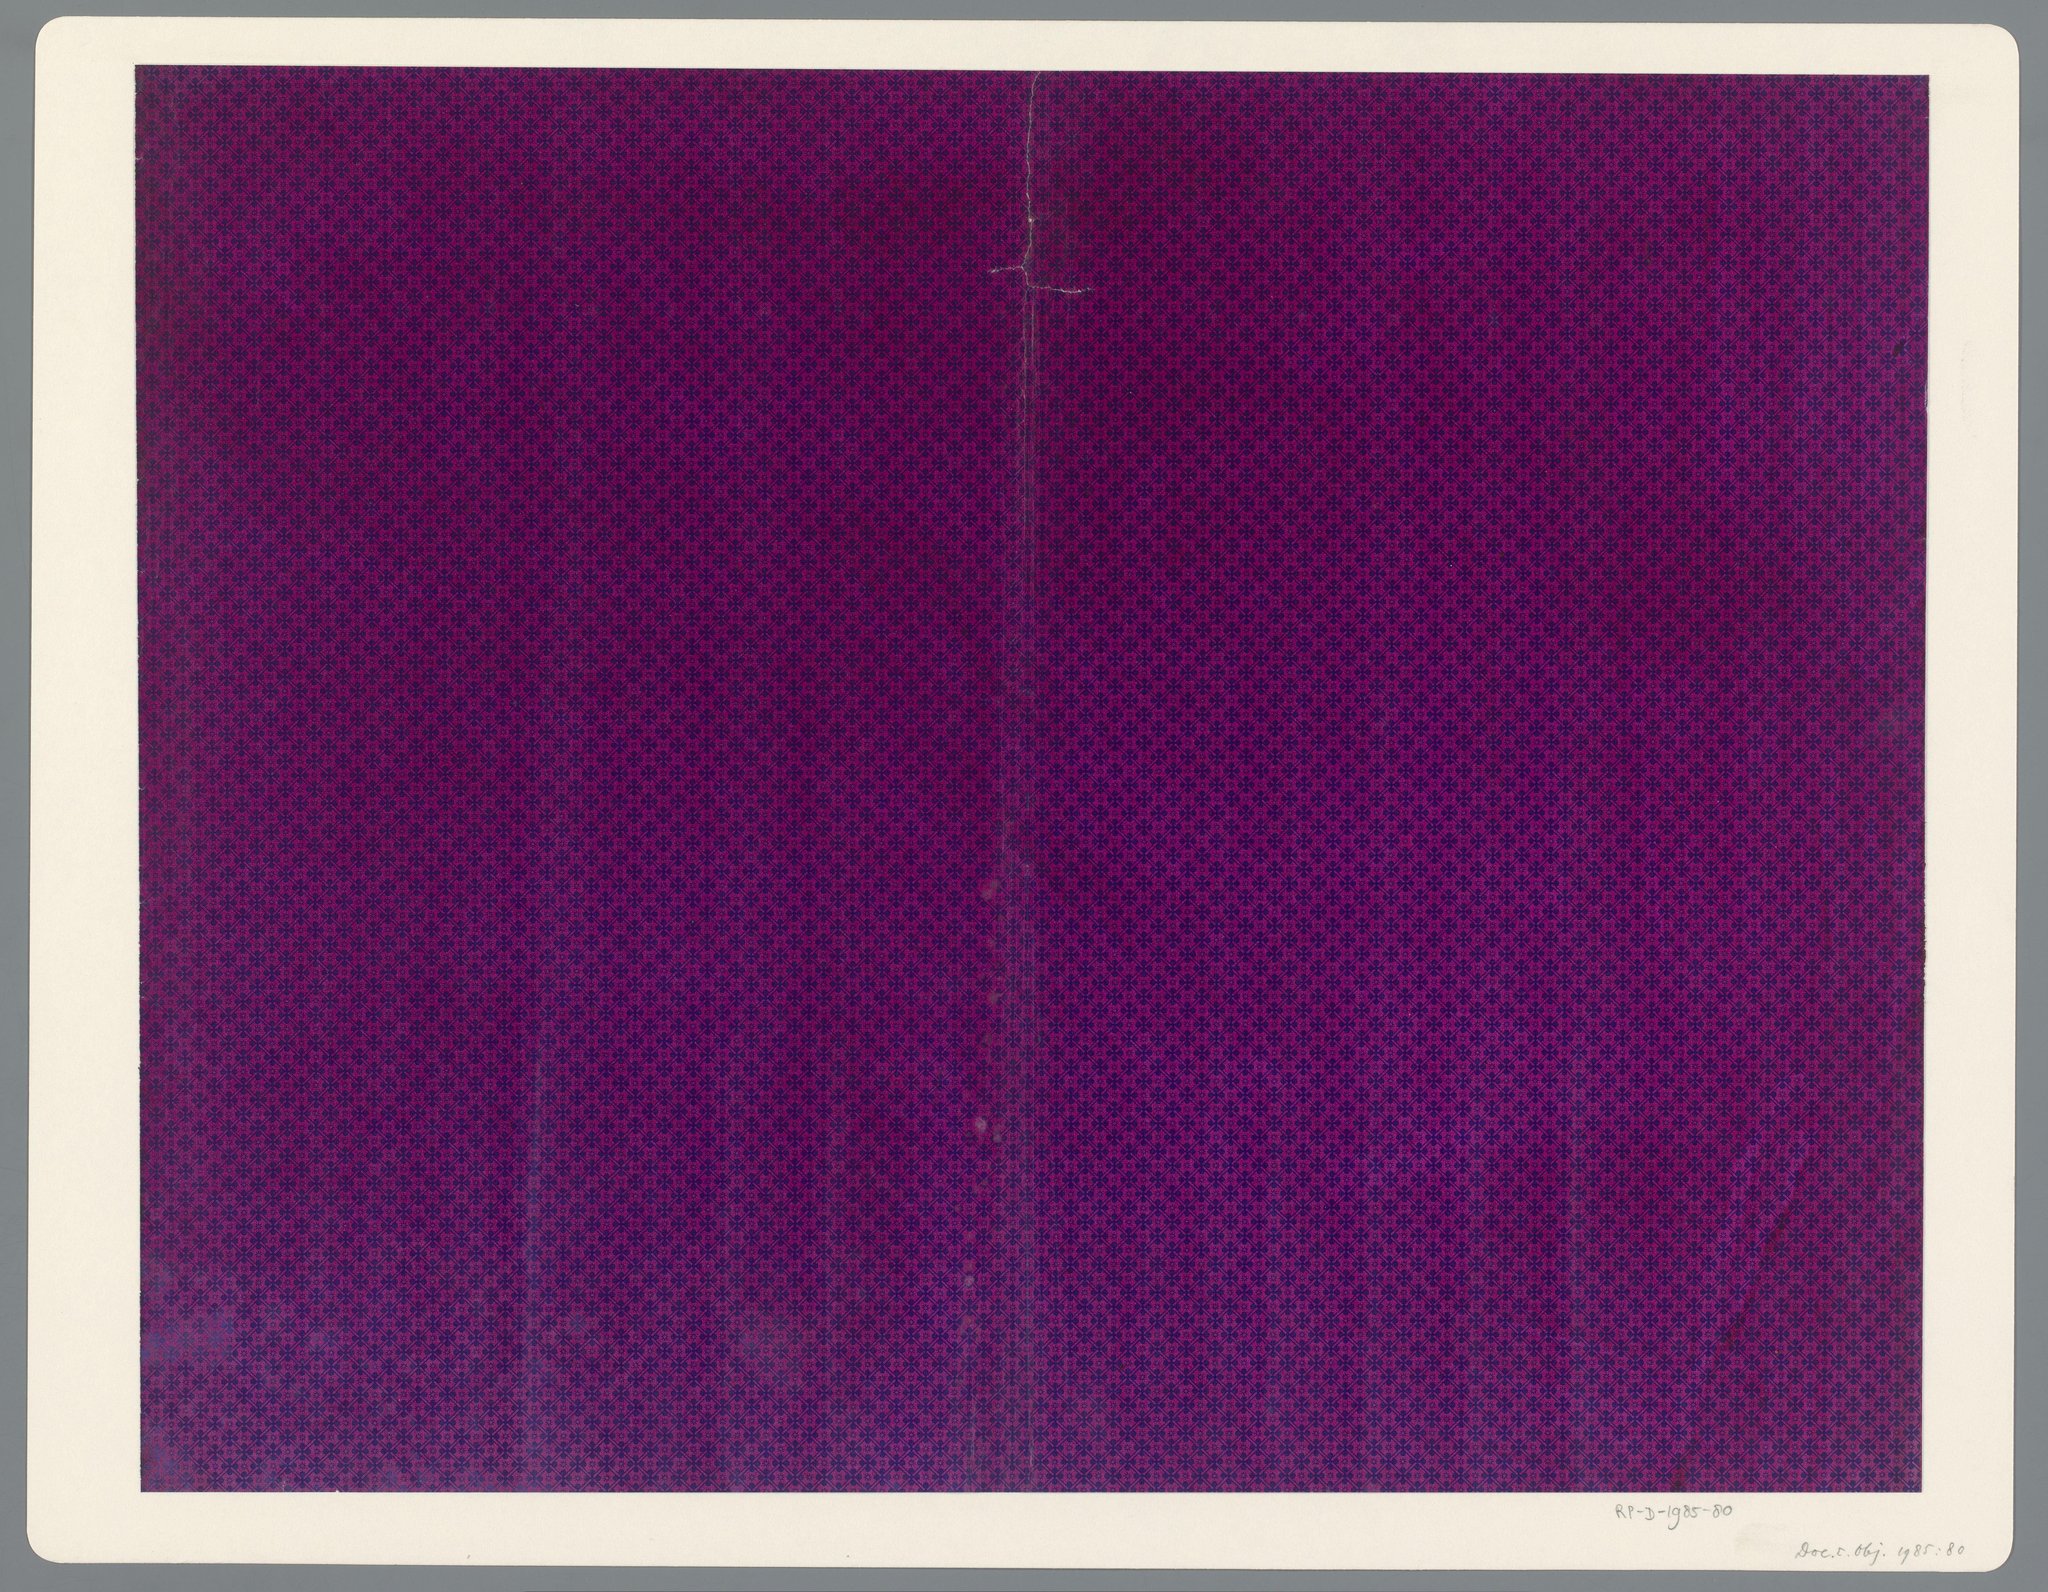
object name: printed paper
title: Blad met ruitenpatroon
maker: Anonymous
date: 1880-1950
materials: ink, paper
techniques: mechanical printing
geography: aschaffenburg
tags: ornament ~ geometric motifs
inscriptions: collector's mark: Lugt 2228, collector's mark: Lugt 2760